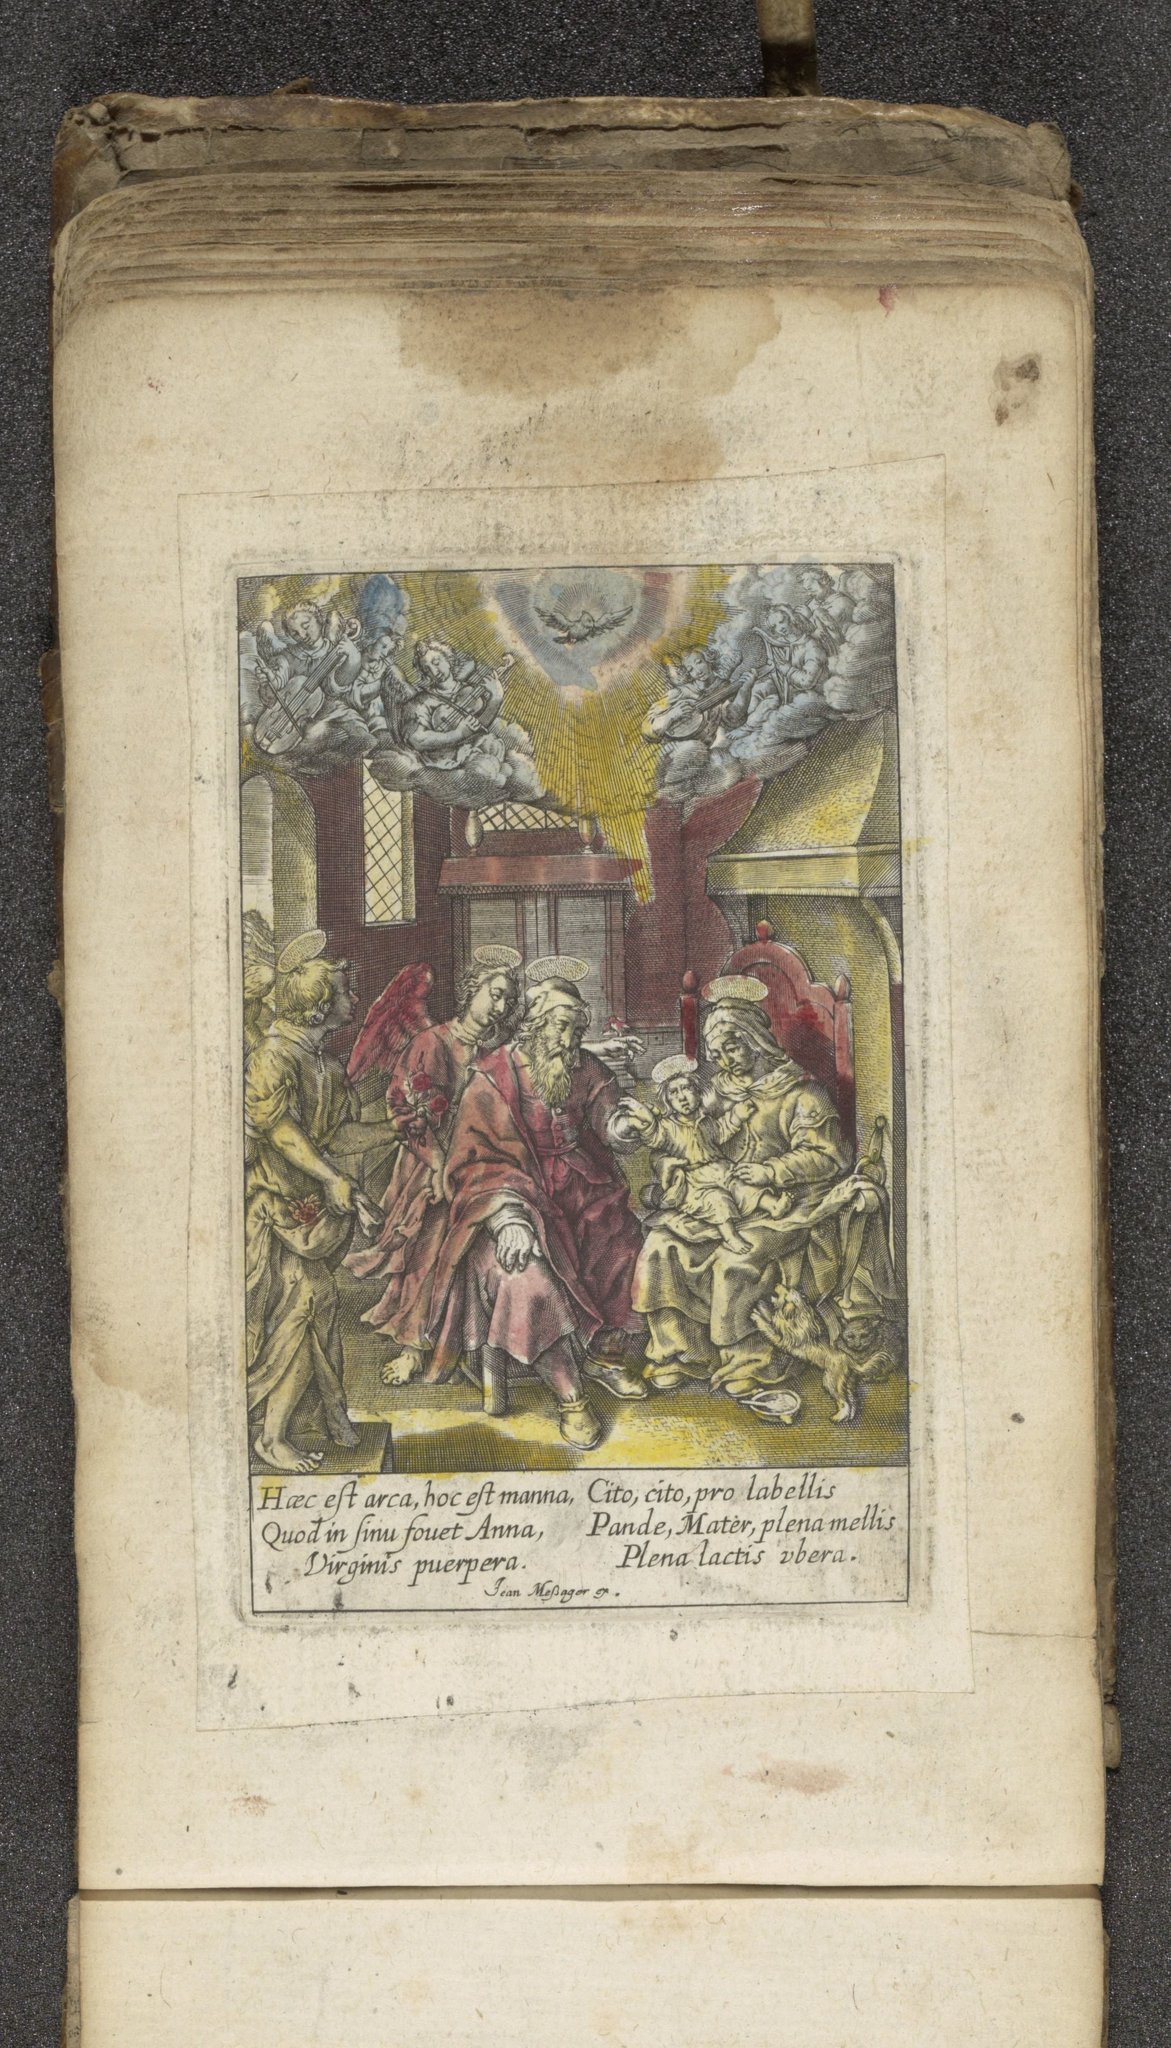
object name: album leaf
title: Vita Deiparae Virginis Mariae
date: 1590-1649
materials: paper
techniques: colour, engraving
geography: paris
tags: (joachim and anna with) the baby mary (+ angel(s)), holy ghost represented as a dove (in flames)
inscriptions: inscription: ‘77’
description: De jonge Maria zit op de schoot van haar moeder Anna. Naast hen zit haar vader Joachim. Ze krijgen bezoek van twee engelen die hen bloemen brengen. In de lucht omgeven door hemelse stralen de Heilige Geest als duif, omringd door musicerende engelen. In de marge een zesregelig onderschrift, in twee kolommen, in het Latijn. De prent maakt deel uit van een album.